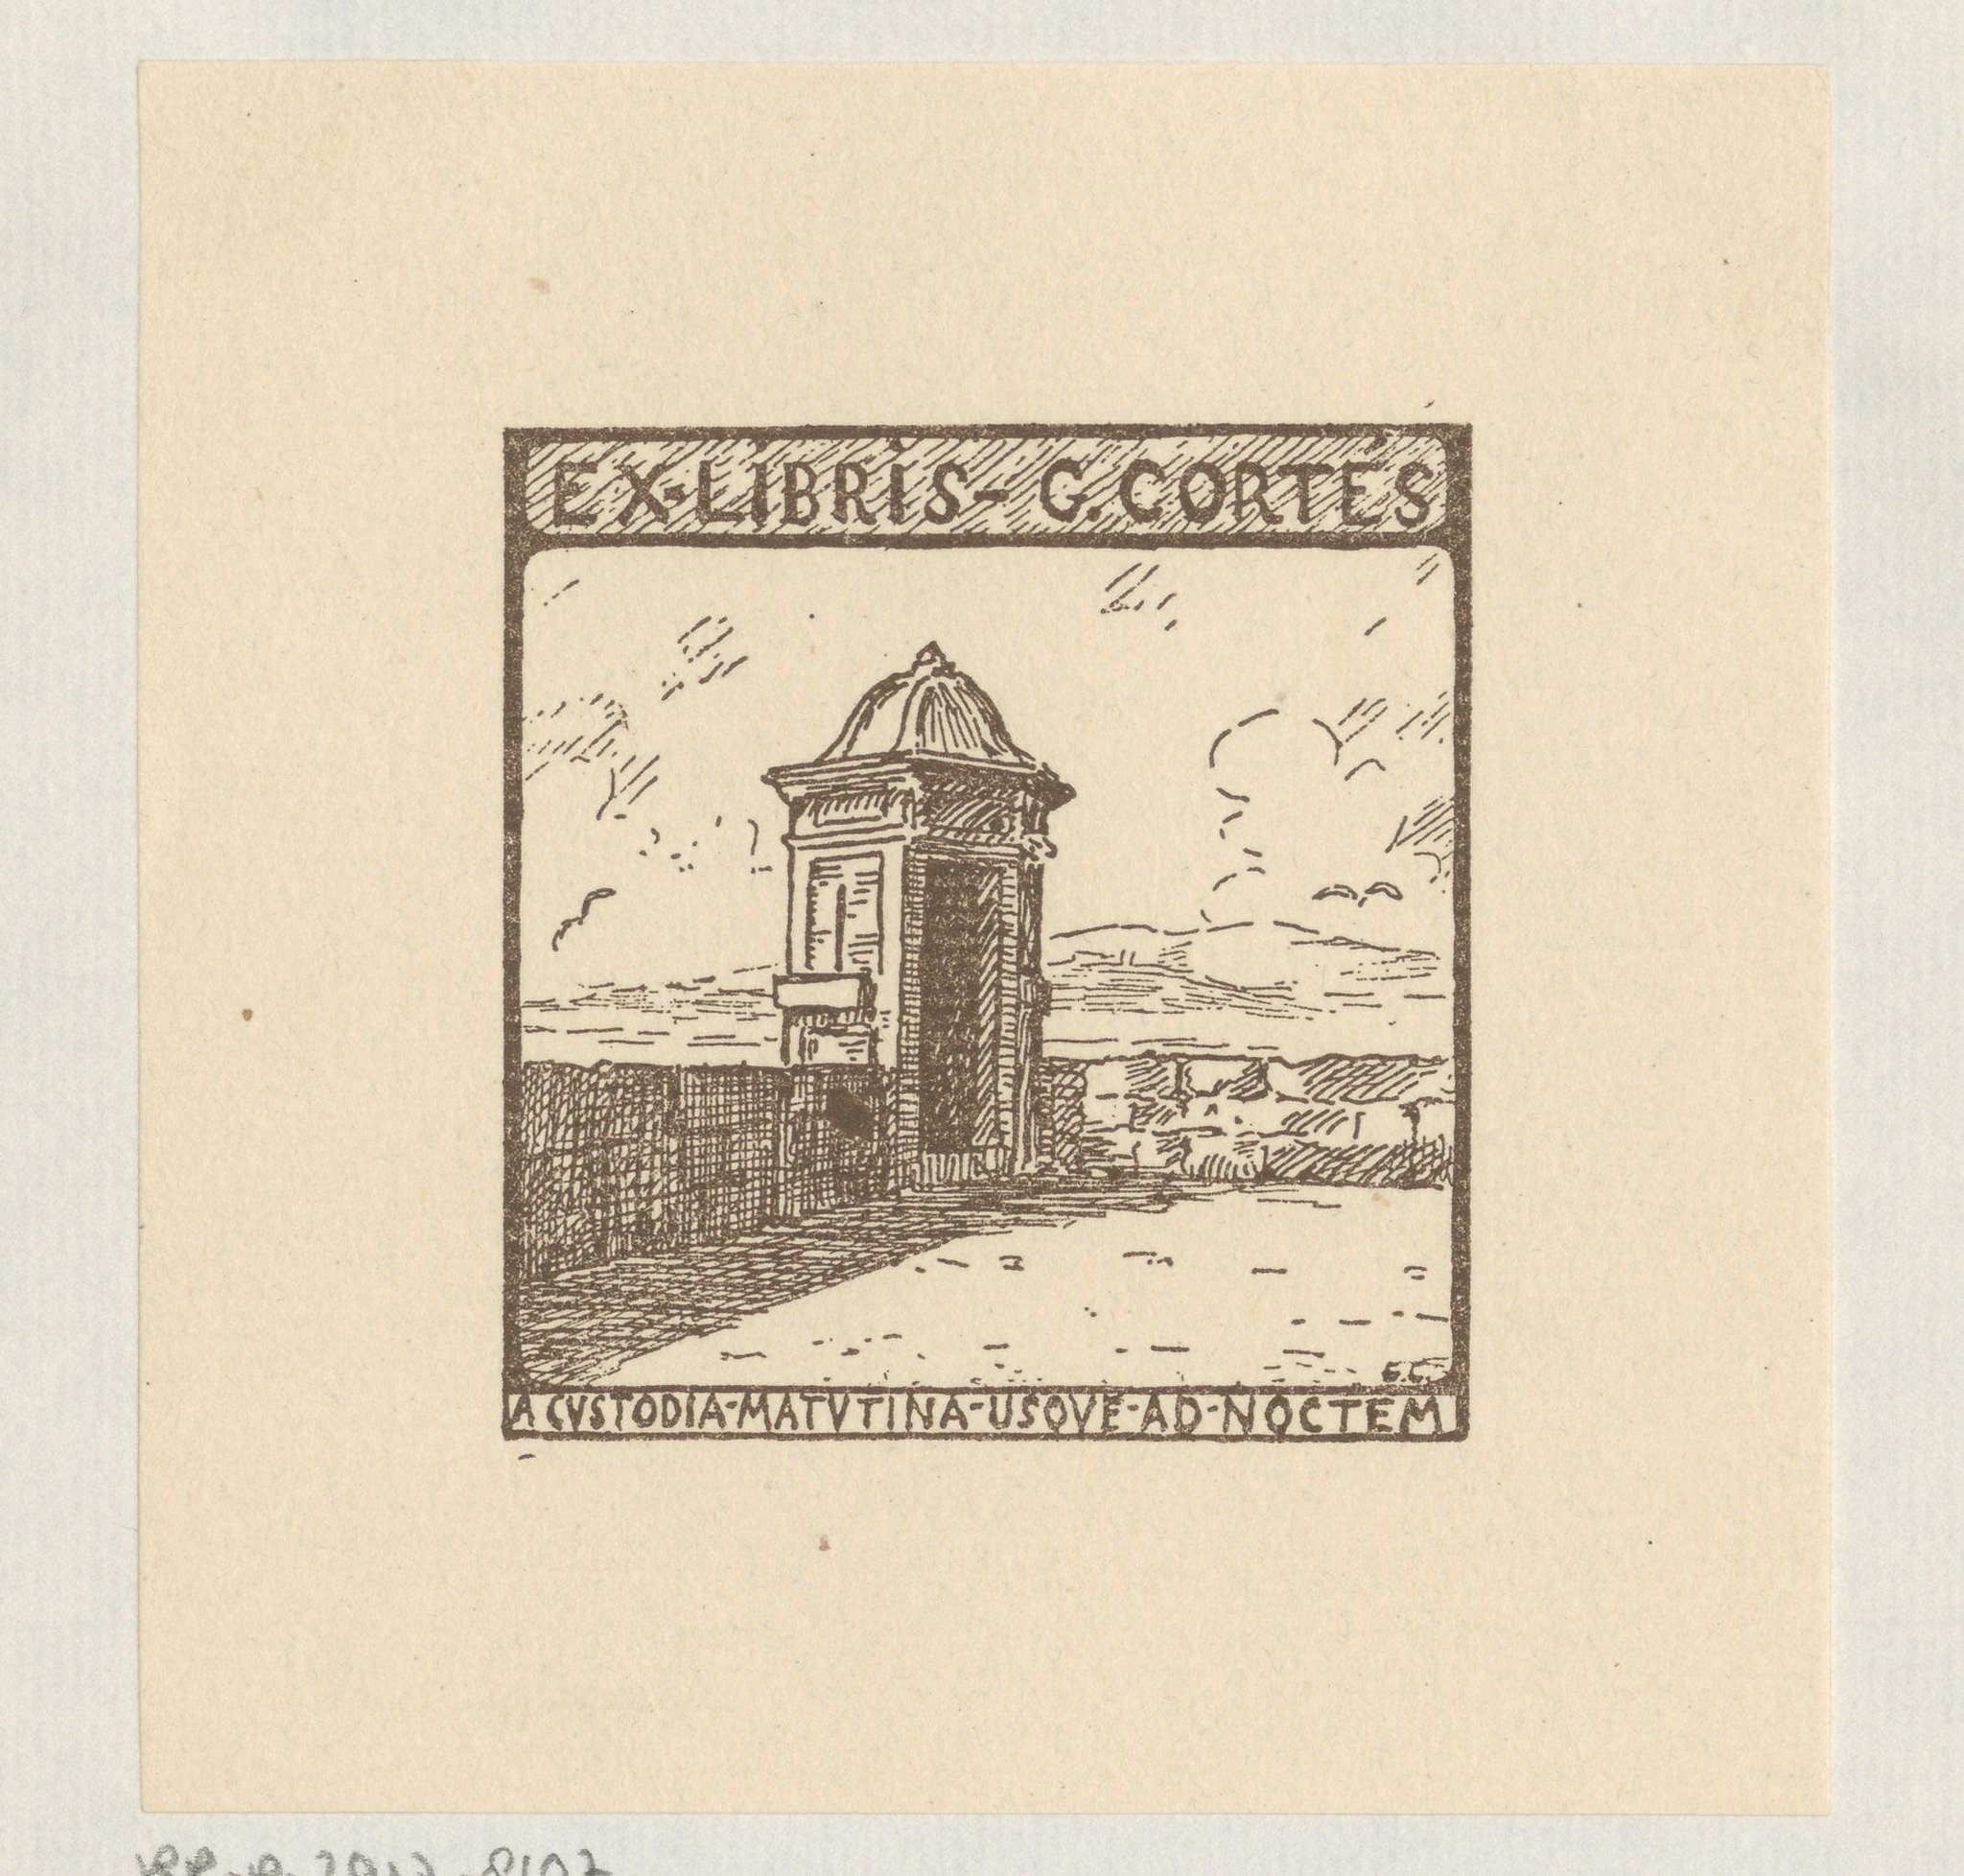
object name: bookplate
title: Ex libris van Gabriel Cortés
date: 1880-1949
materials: paper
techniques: printing block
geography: spain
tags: housing